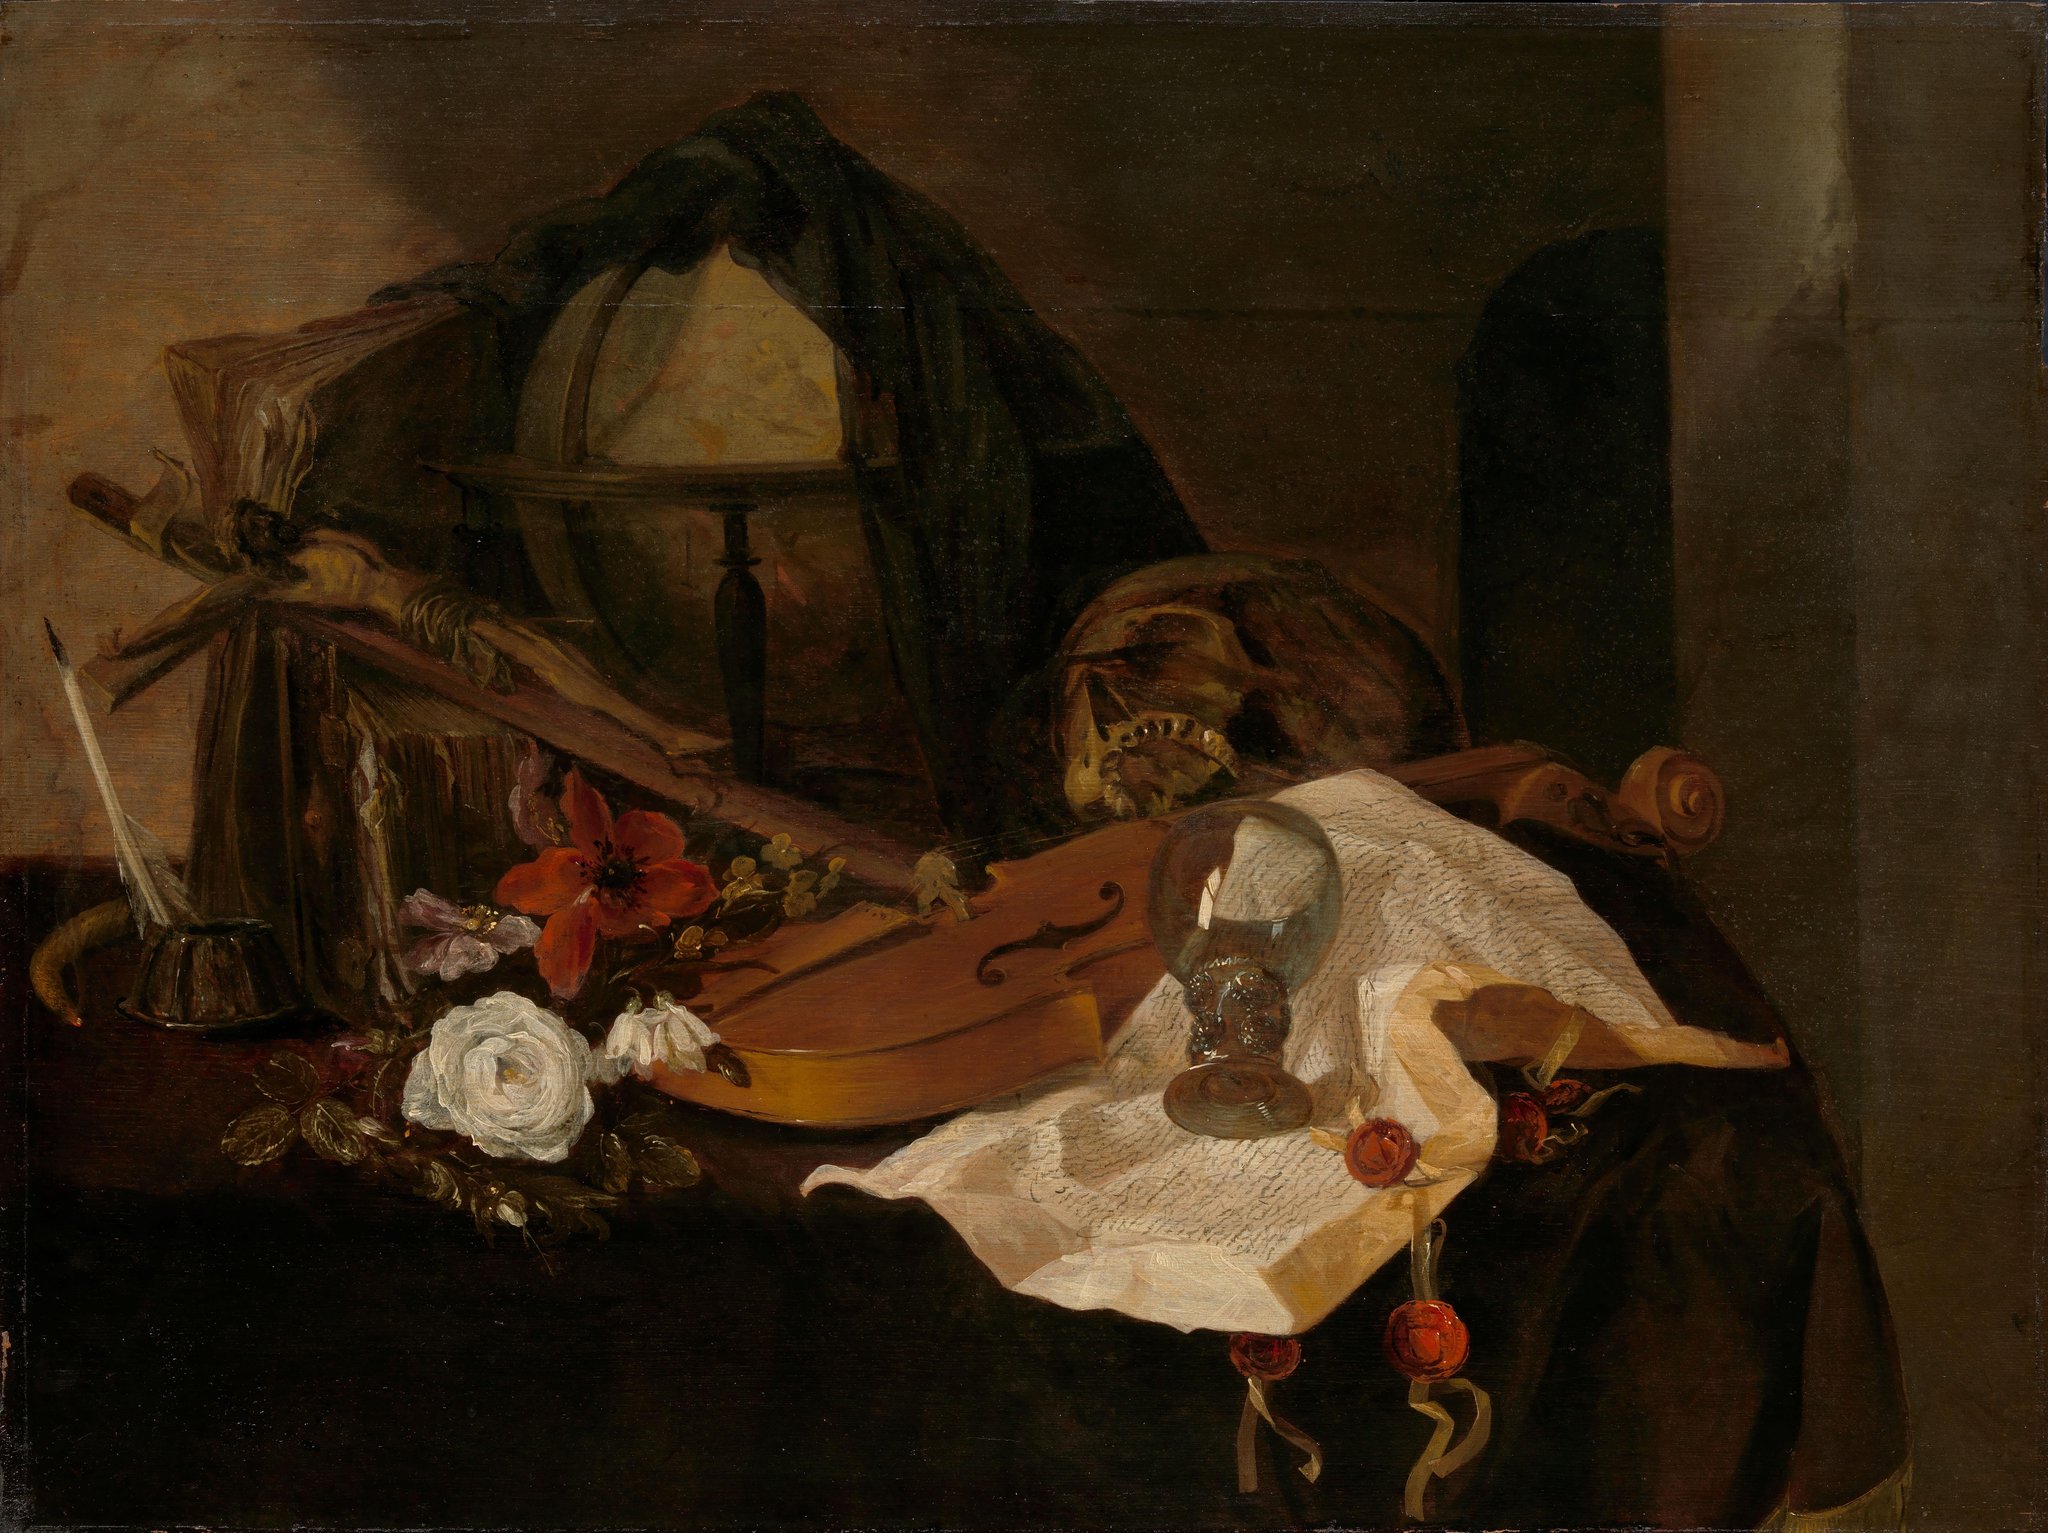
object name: painting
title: Vanitas Still Life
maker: jacques de claeuw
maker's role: painter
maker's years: 1623-1694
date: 1650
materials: oil, panel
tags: (personifications of) 'vanitas', the vanity of human life; fragilità humana, fugacità delle grandezze & della gloria mondana, meditatione della morte, opera vana, piacere vano, vana gloria, vanità (ripa), still life of miscellaneous objects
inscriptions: signature and date: ‘JDClaew f. 1650’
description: Vanitas stilleven. Op een tafel liggen een viool, een kruisbeeld, een schedel, bloemen, een roemer, een document met lakzegels, boeken, een inktstel en een globe.